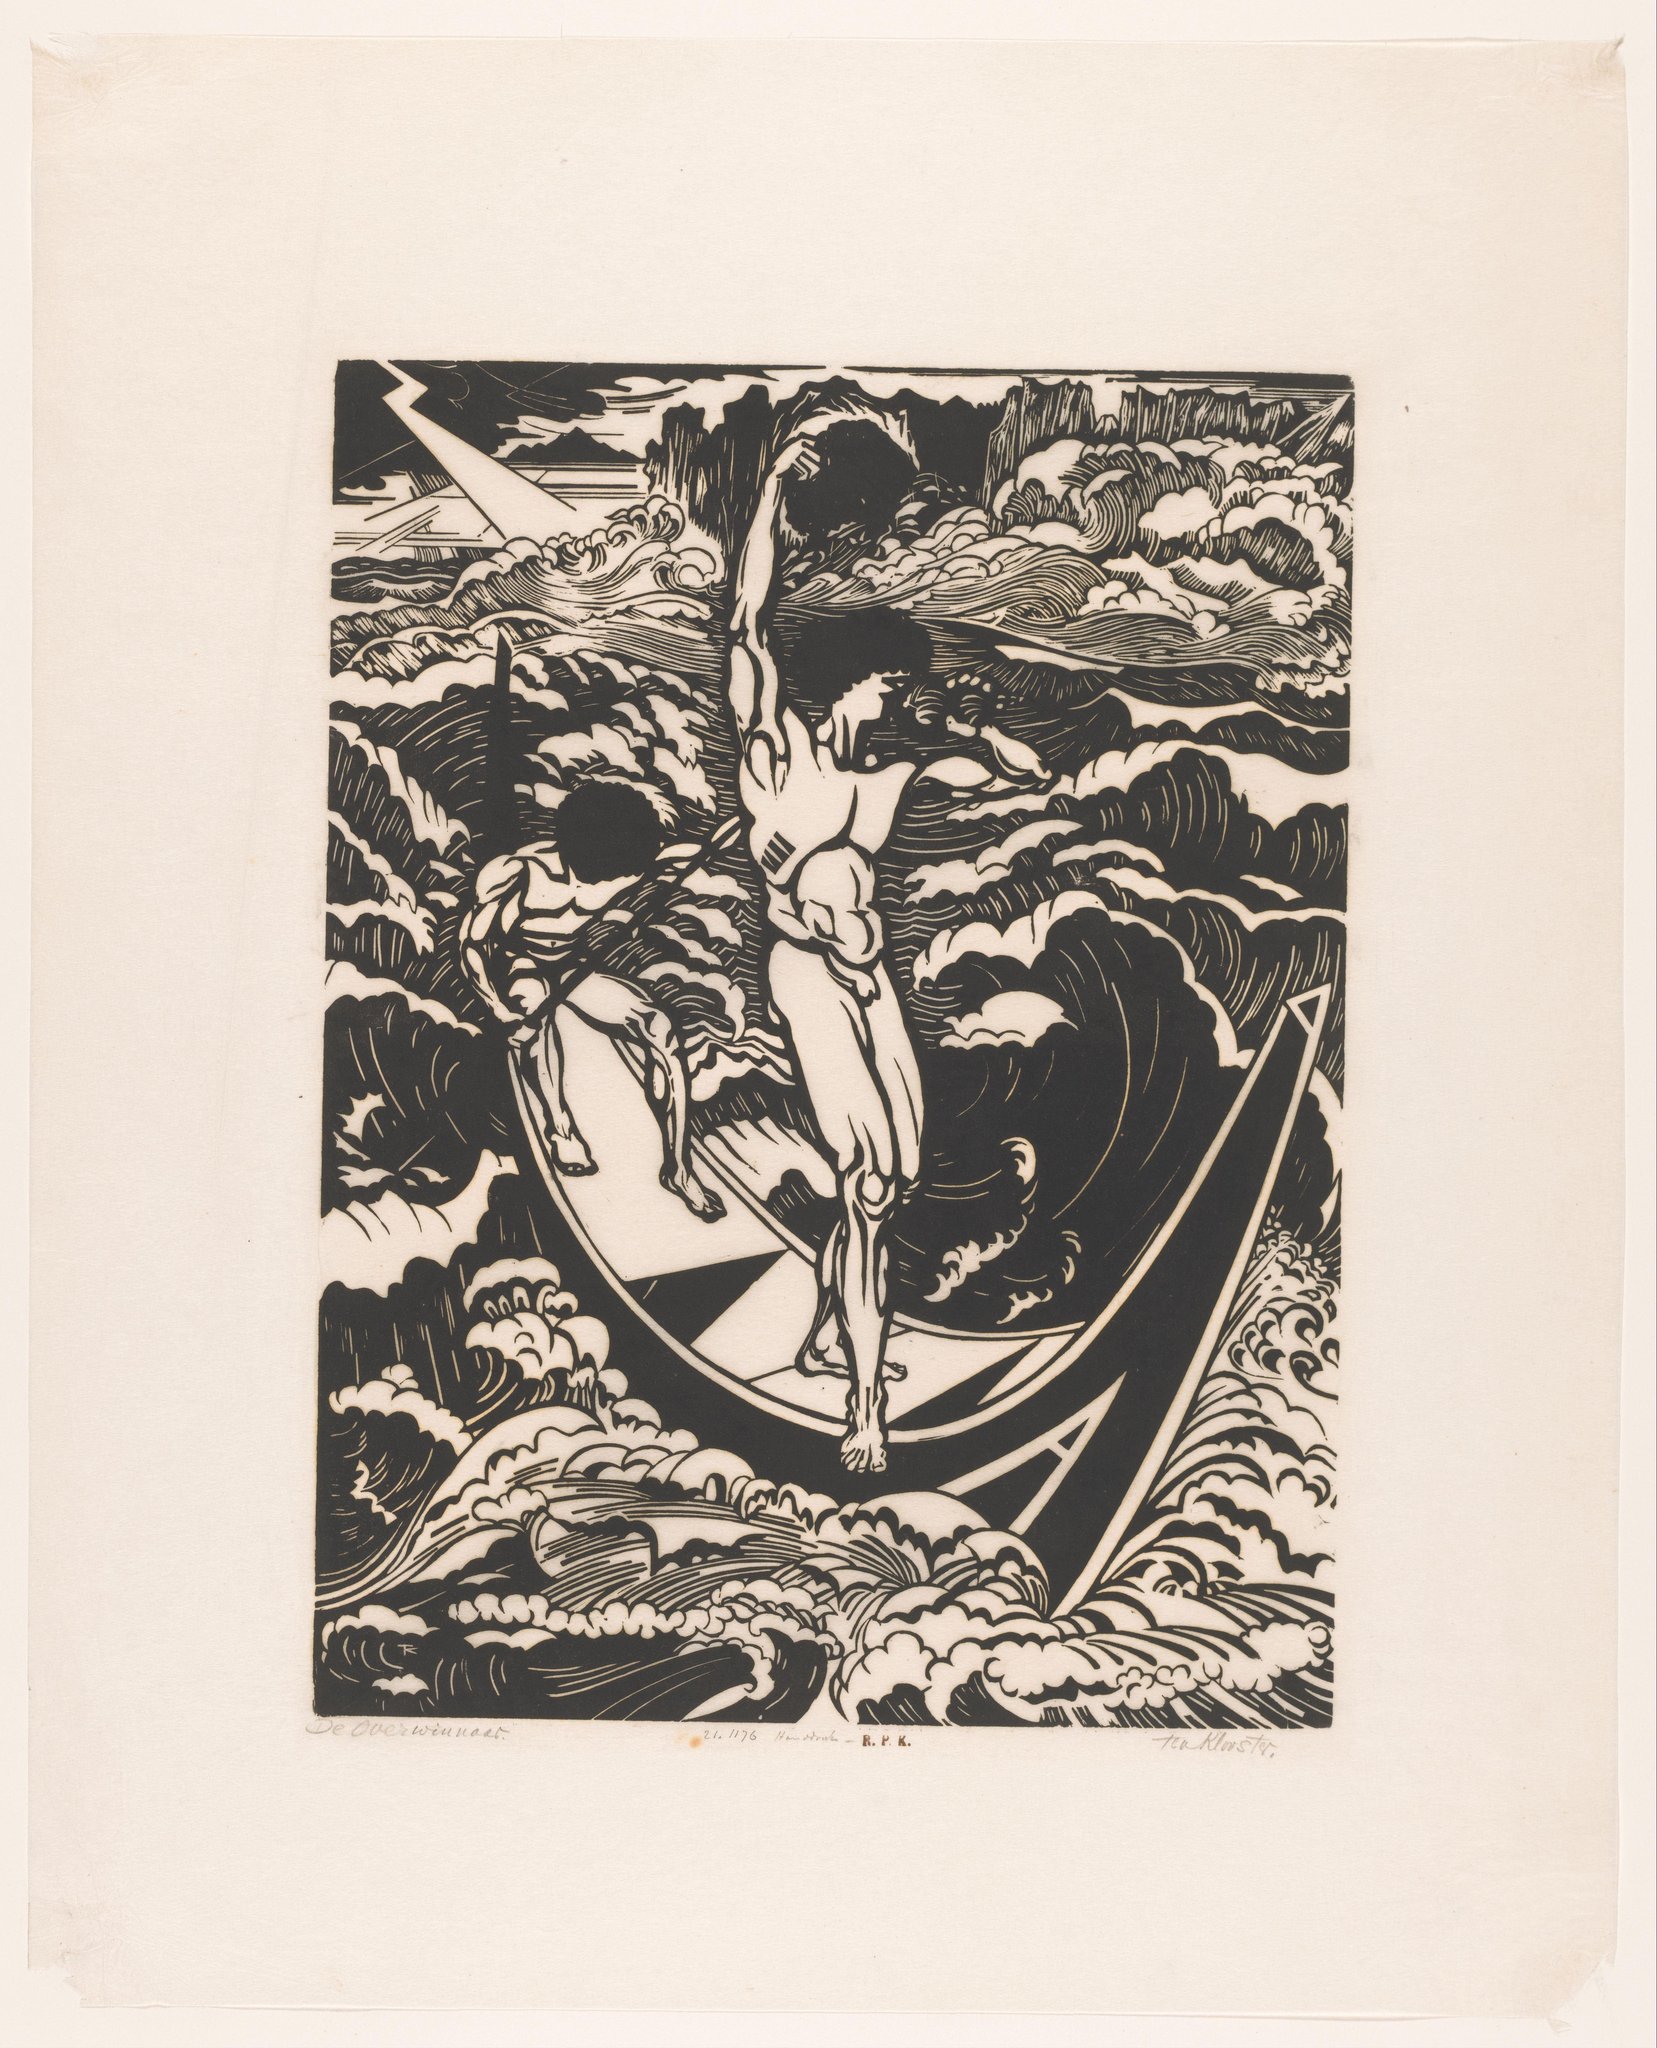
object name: print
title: De overwinnaar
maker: johannes frederik engelbert ten klooster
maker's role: draughtsman, print maker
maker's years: 1873-1940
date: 1919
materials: paper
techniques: woodcut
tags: rowing-boat, canoe, etc., storm at sea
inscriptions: collector's mark: Lugt 2233